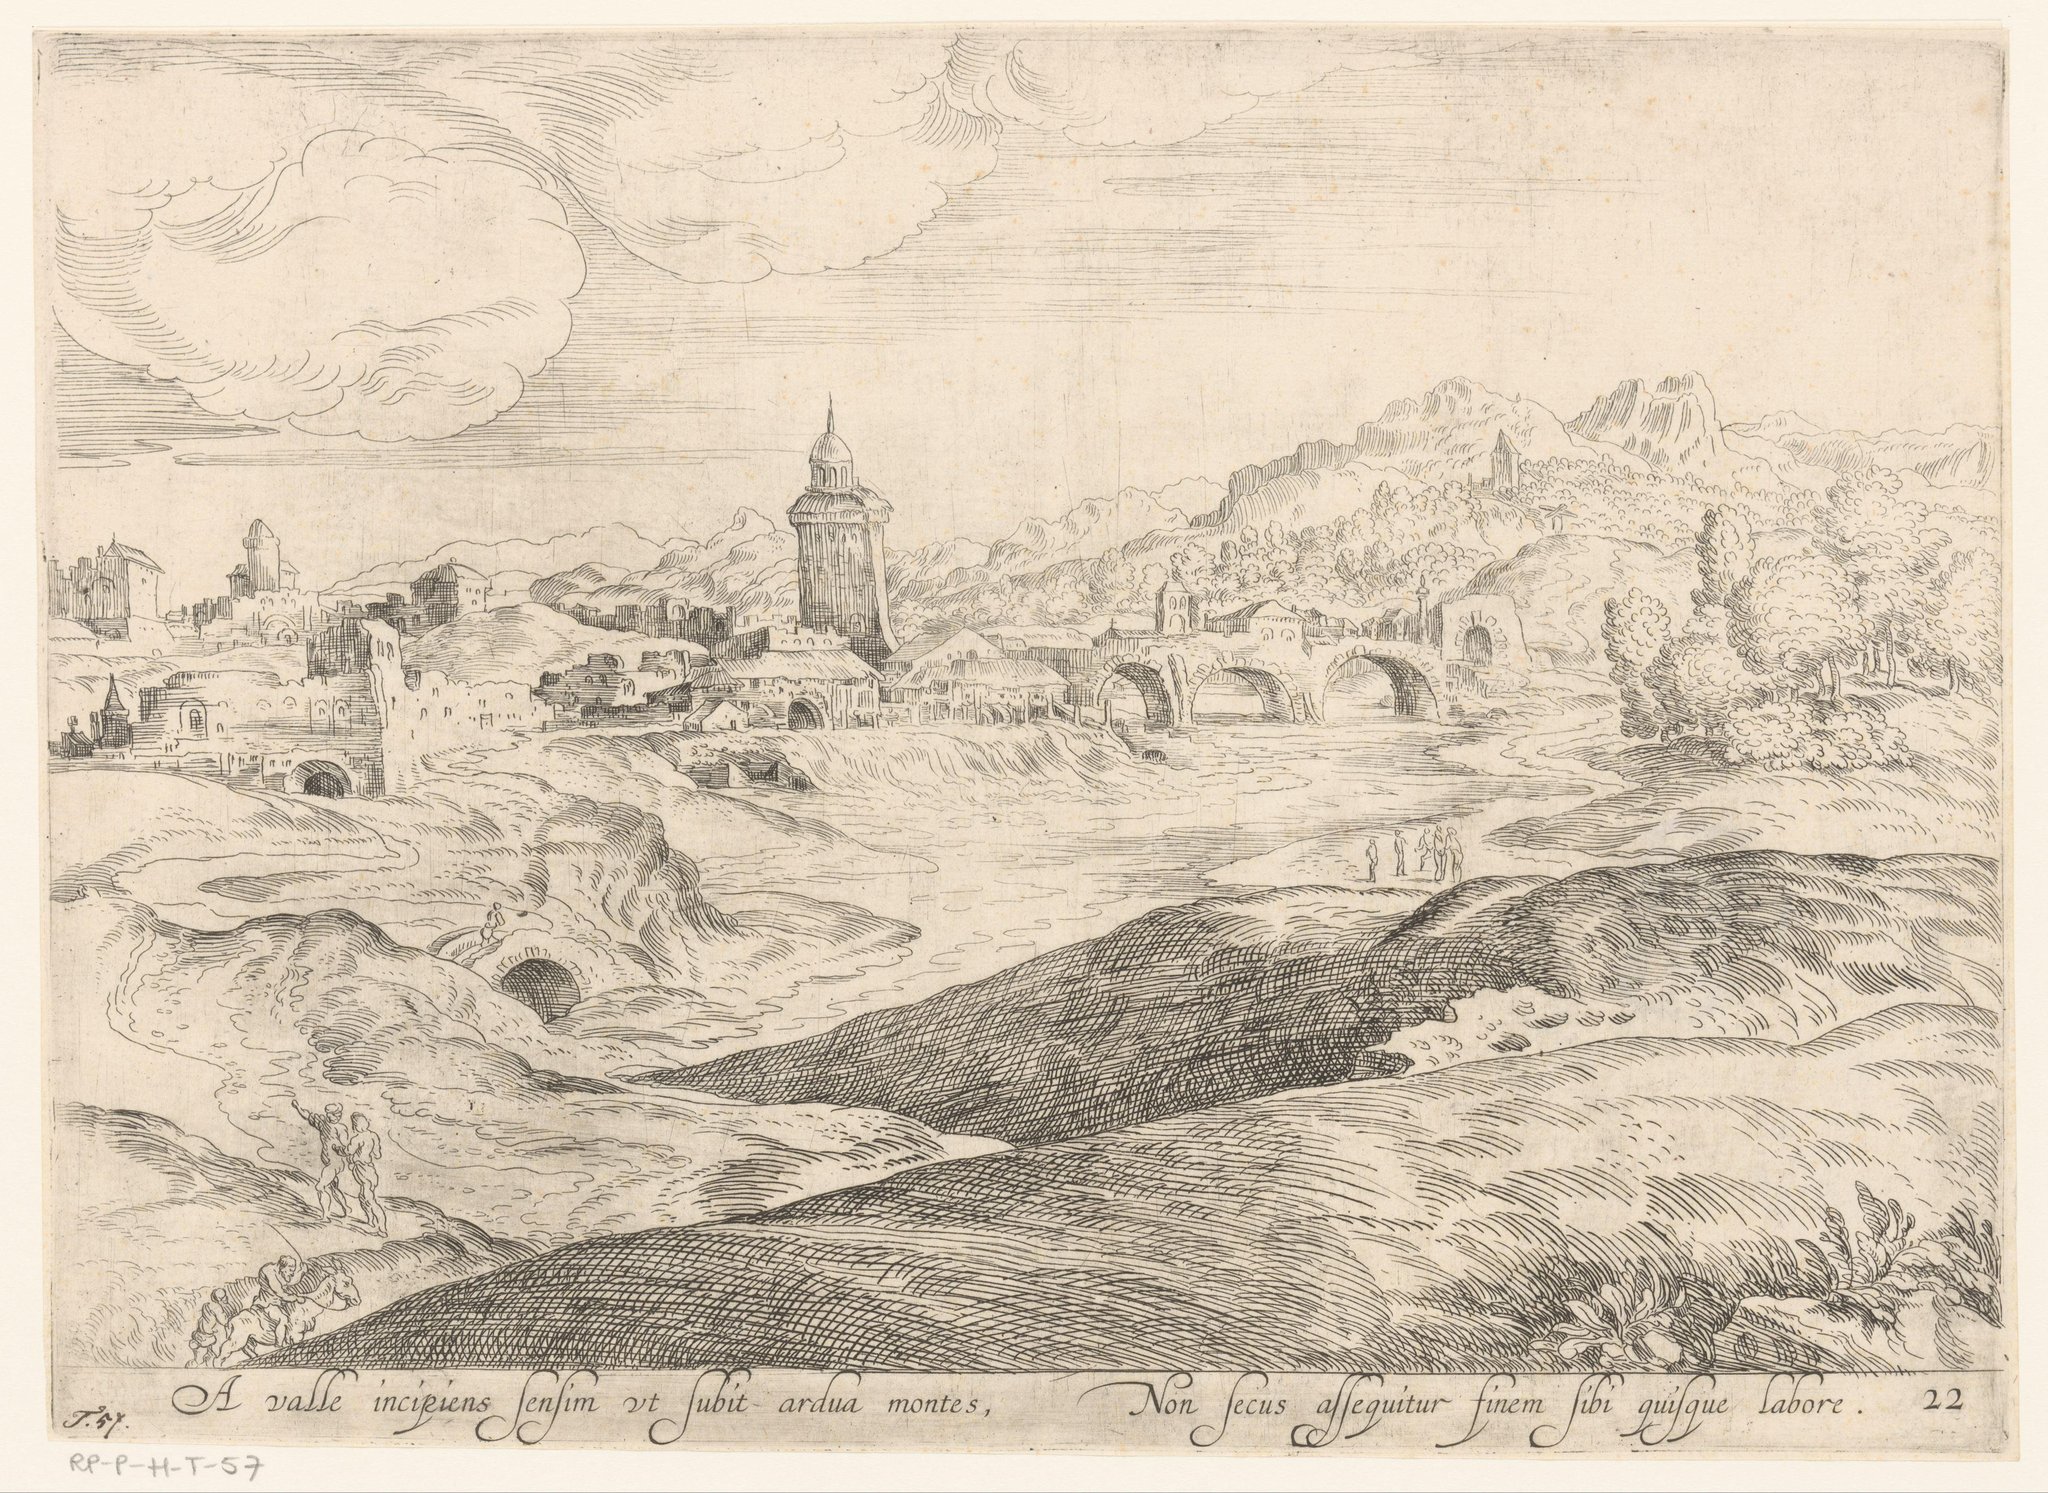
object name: print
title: Landschappen naar Domenico Campagnola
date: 1600-1699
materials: paper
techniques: etching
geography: italy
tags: city-view, and landscape with man-made constructions, landscapes, bridge in village across river, canal, etc. - ii - ideal landscapes, river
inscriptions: collector's mark: Lugt 11, number: ‘T. 57’, collector's mark: ‘Hinloopen’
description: Rivierlandschap met een brug over de rivier. Links een nederzetting. Op de achtergrond rechts liggen heuvels. Titel in het Latijn in ondermarge. Genummerd rechtsonder: 22.